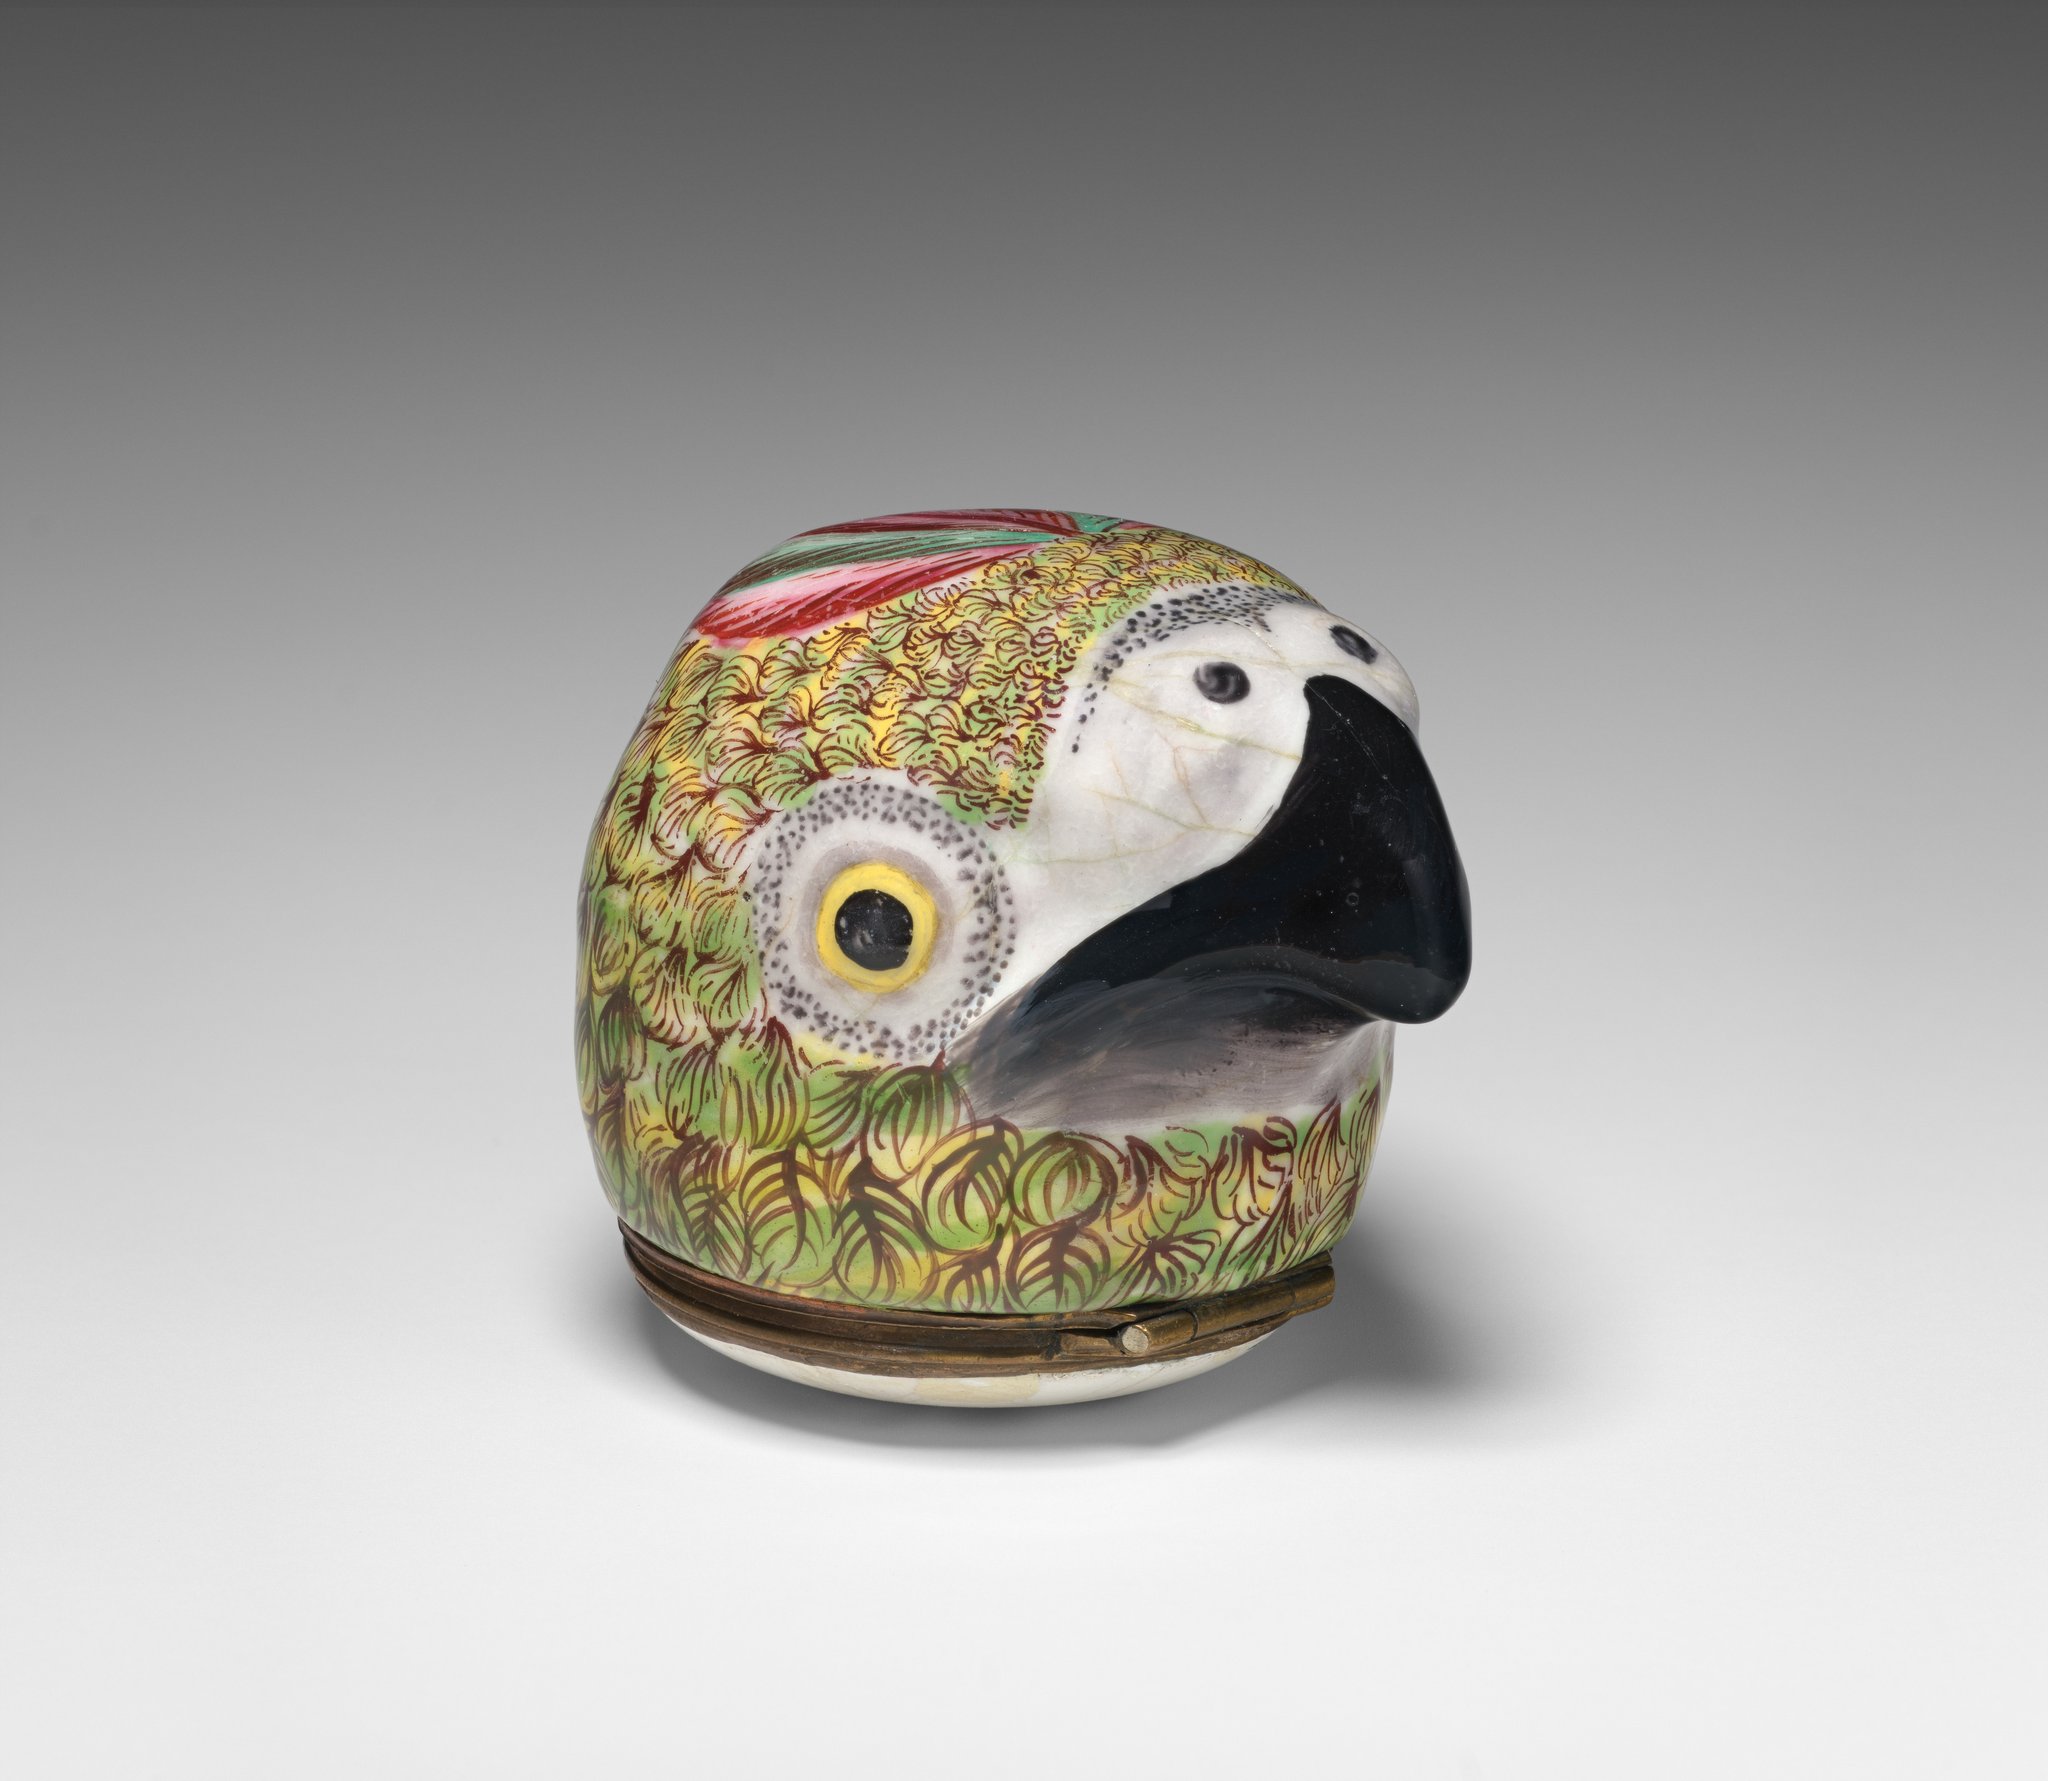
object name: bonbonnière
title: Bonbonnière in the form of a parrot's head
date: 1770-1780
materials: copper, enamel